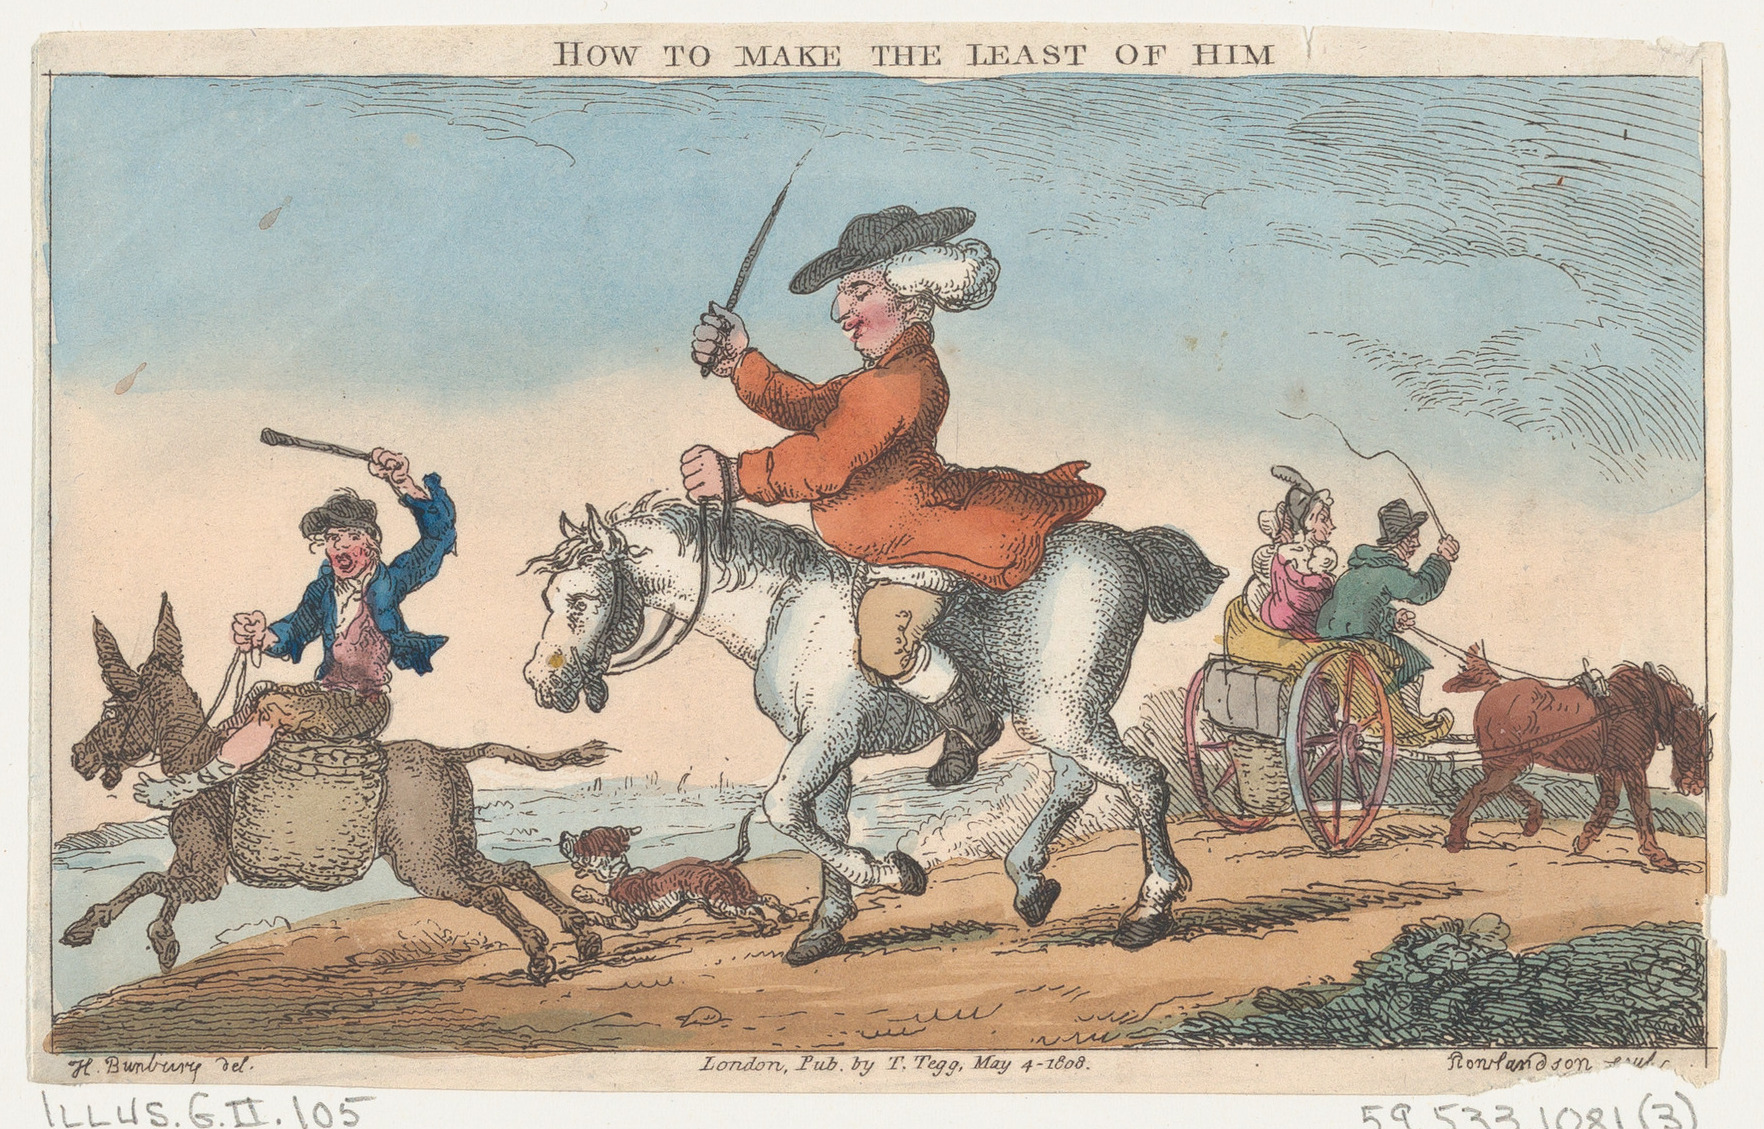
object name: print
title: How to Make the Least of Him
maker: thomas rowlandson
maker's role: artist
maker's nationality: british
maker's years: 1757-1827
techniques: etching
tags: satire,men,dogs,donkeys,horses,carriages